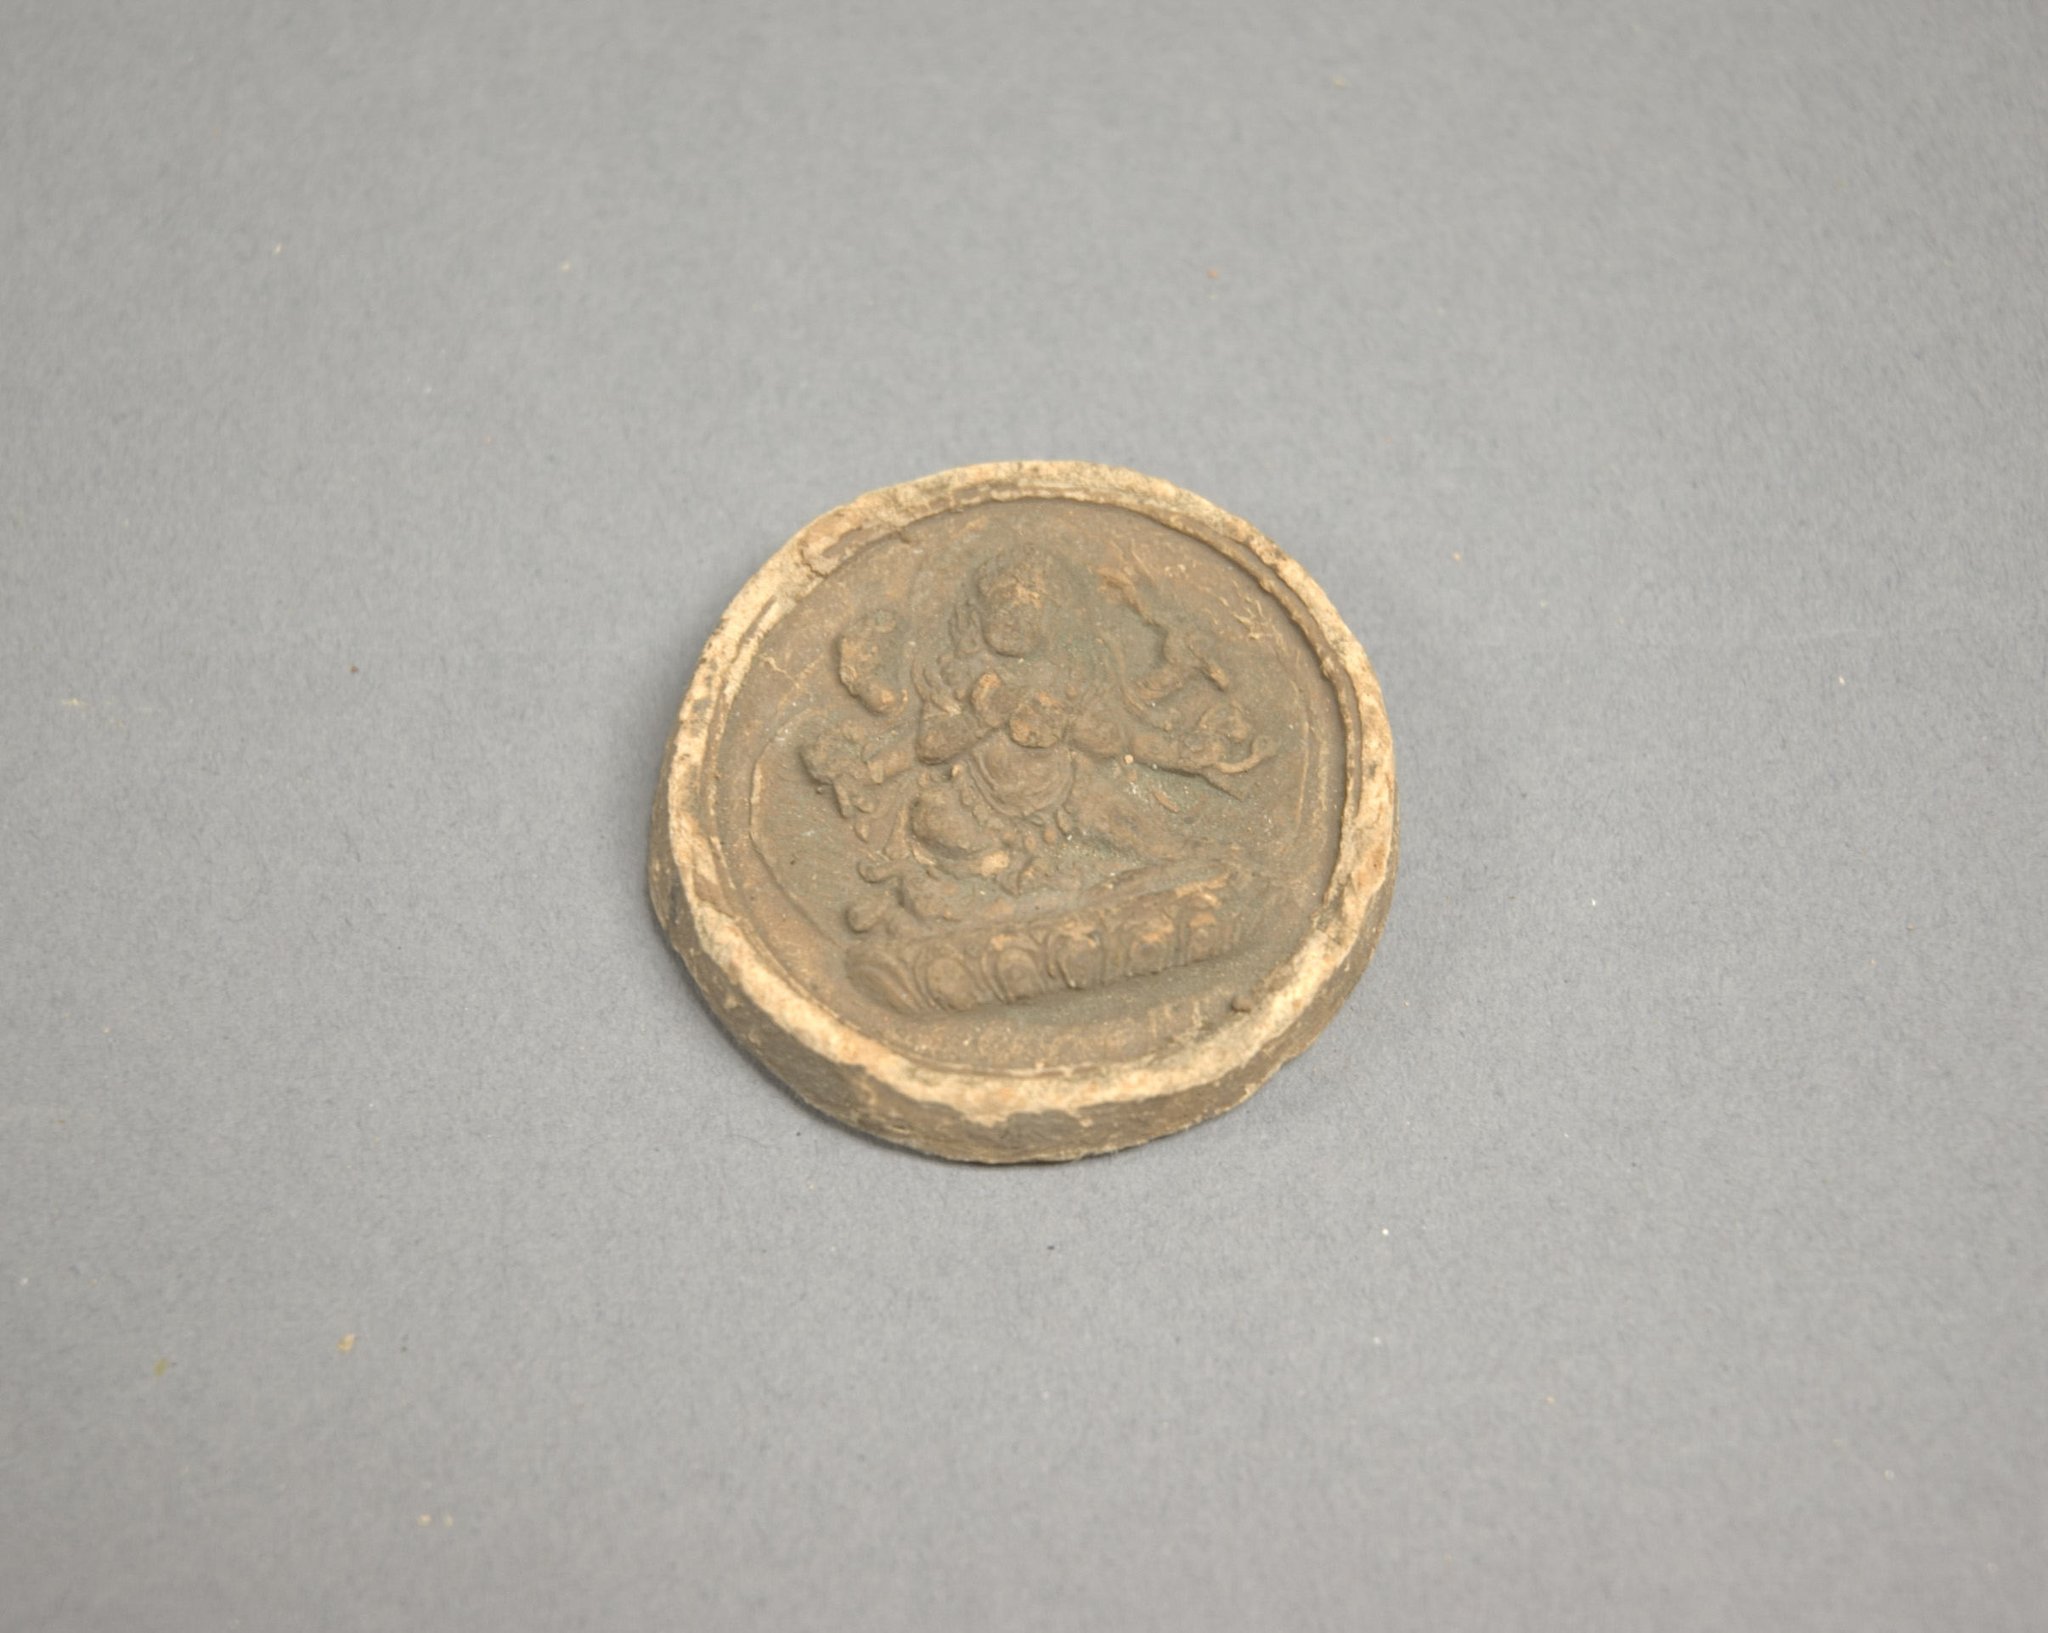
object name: plaque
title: Votive Plaque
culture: tibetan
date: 1368-1643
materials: clay